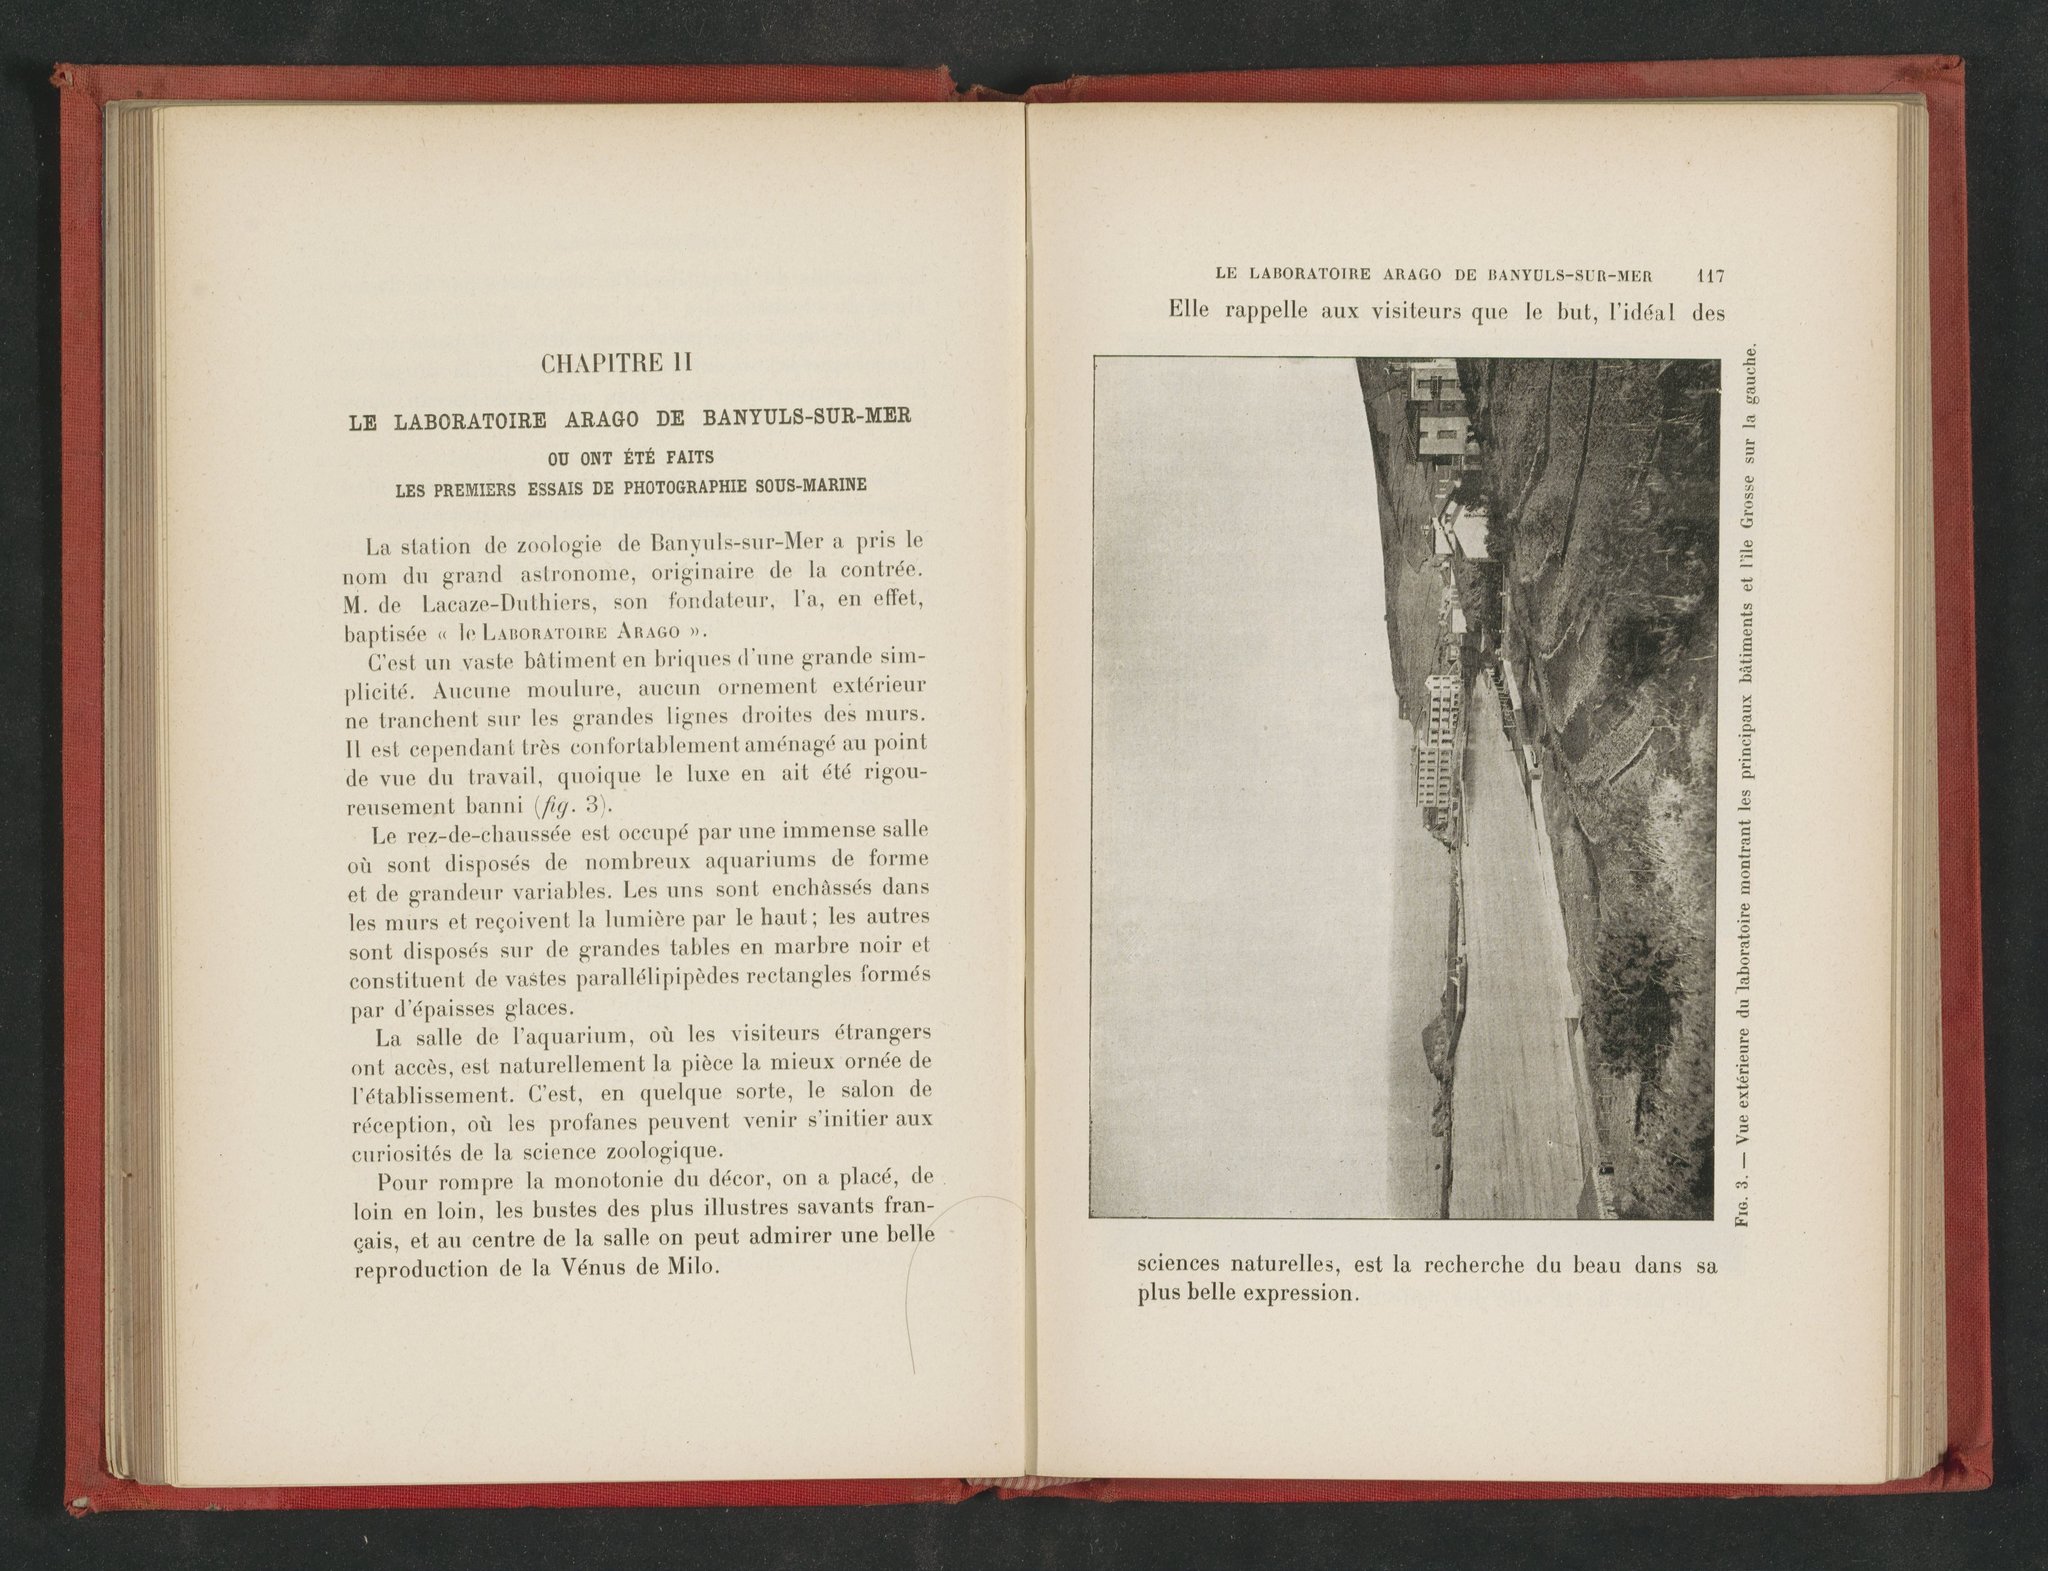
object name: photomechanical print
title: Vue extérieure du laboratoire montrant les principaux bâtiments et l'île Grosse sur la gauche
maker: Anonymous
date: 1890-1900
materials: paper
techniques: autotype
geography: france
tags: gulf, bay, city-view in general; 'veduta'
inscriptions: number: ‘Fig. 3.’